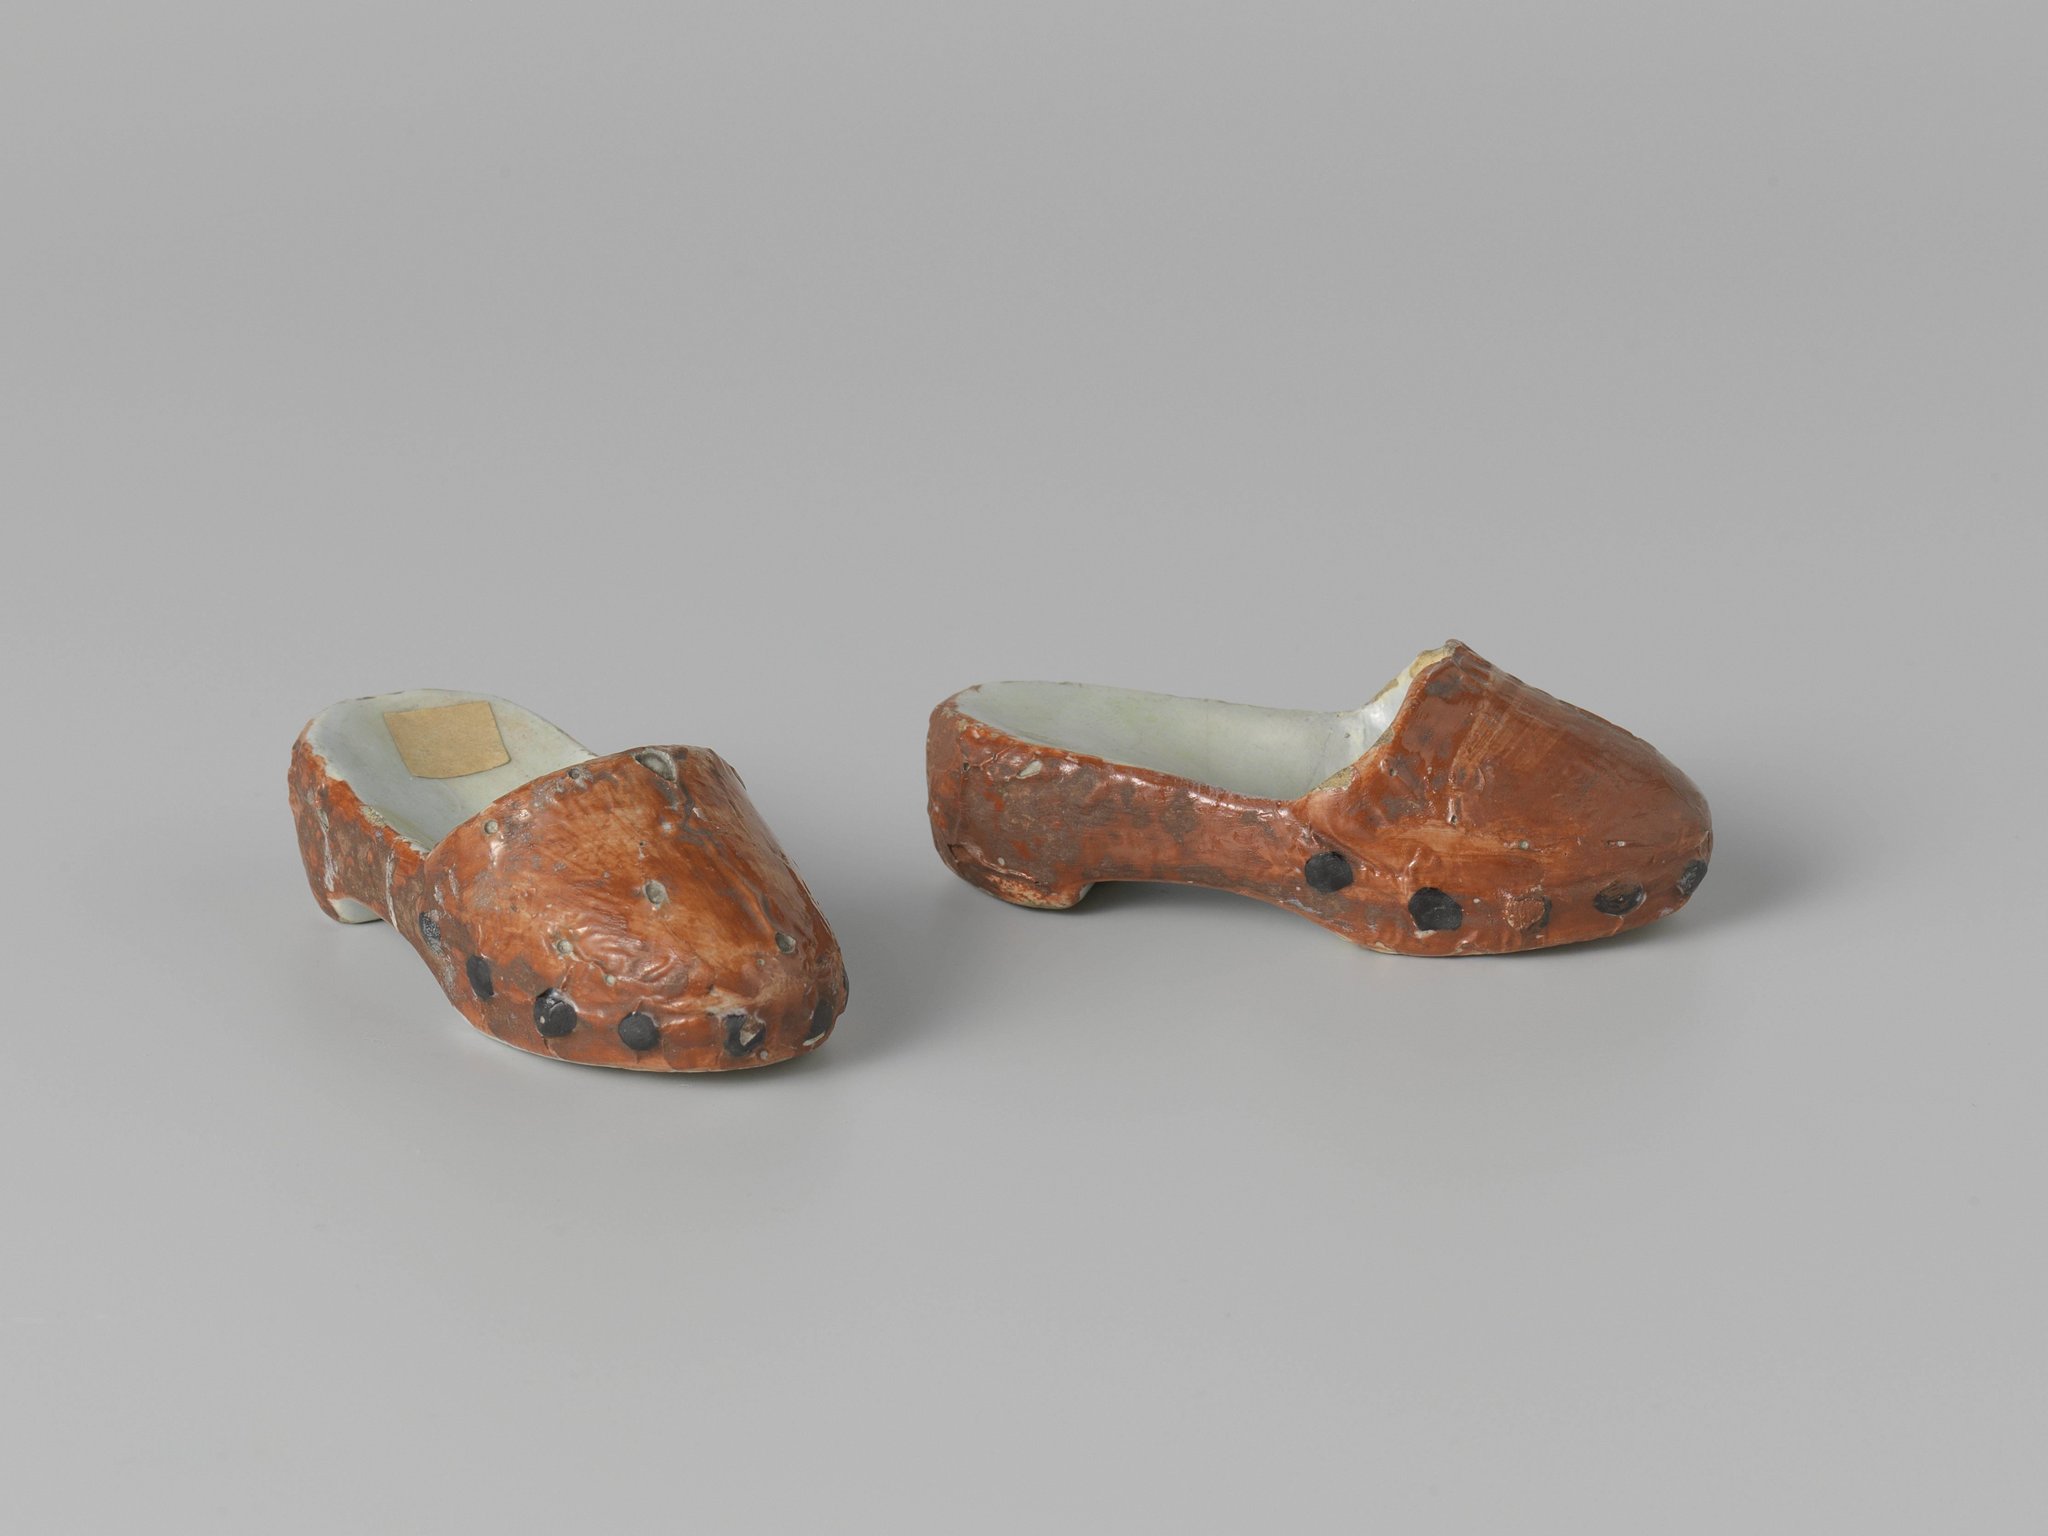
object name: mule shoe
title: Muiltje van faience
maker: Anonymous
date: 1690-1740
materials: faience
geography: delft